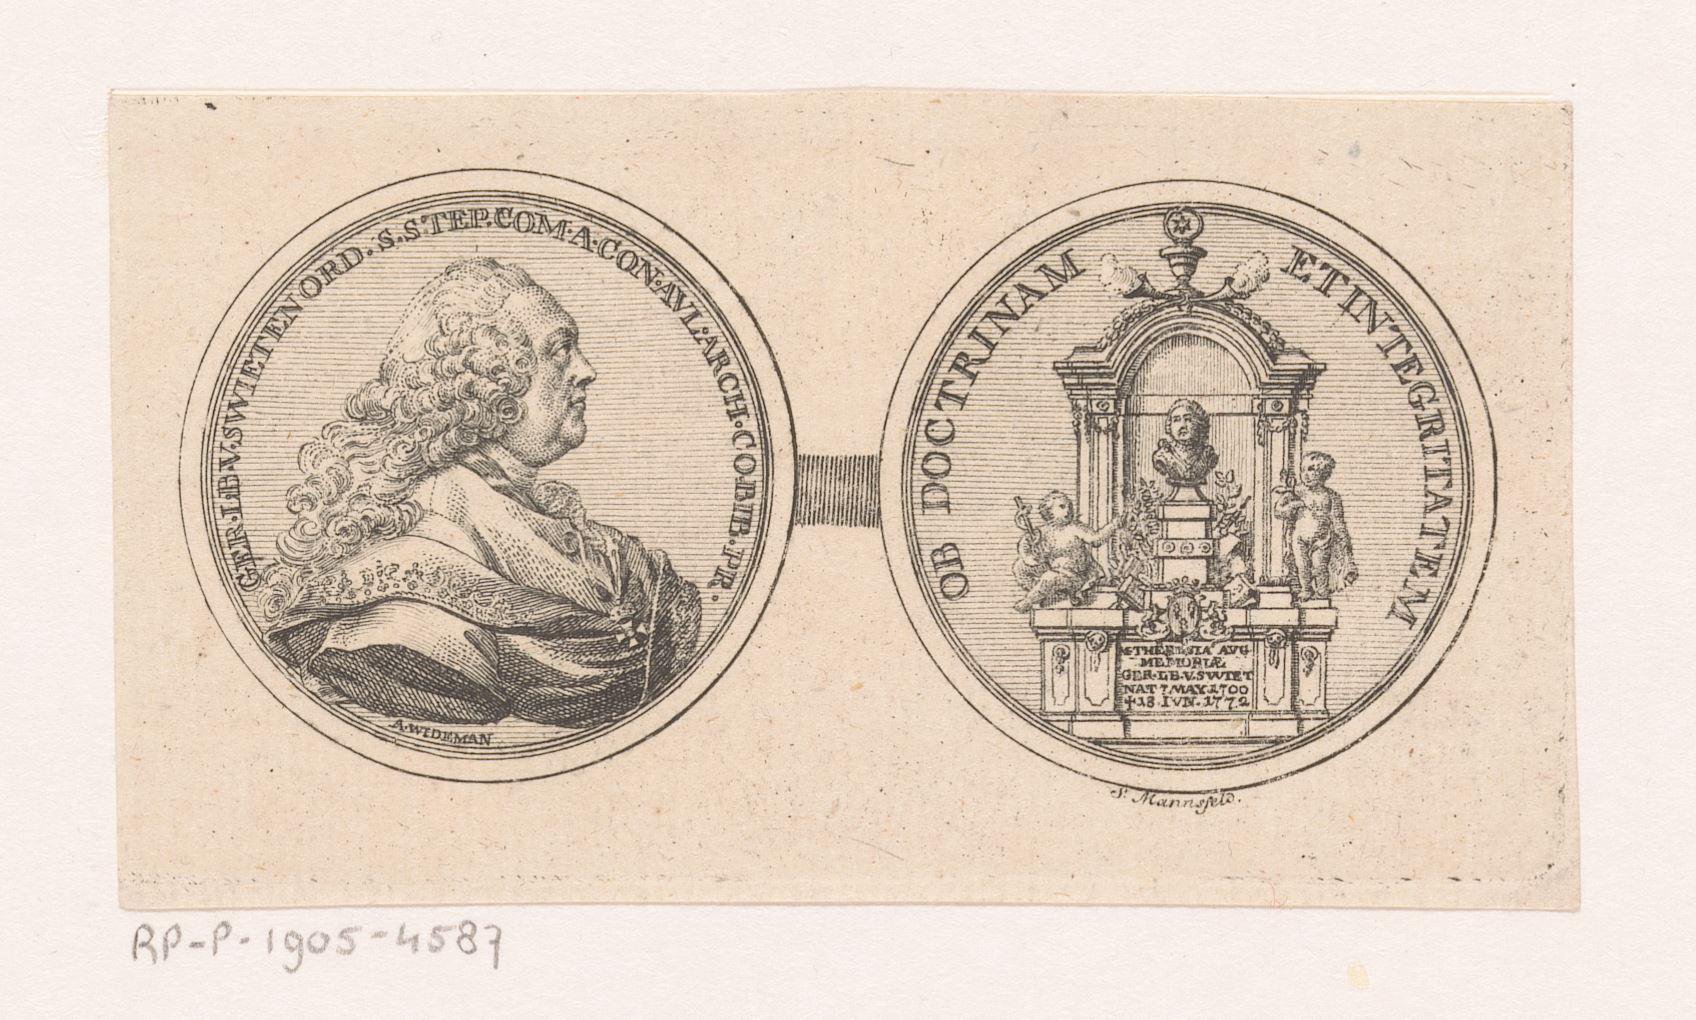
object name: print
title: Penning met het portret en grafmonument van Gerard van Swieten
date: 1772-1816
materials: paper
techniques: etching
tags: leiden, vienna, historical persons, memorial medal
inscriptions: collector's mark: Lugt 2228